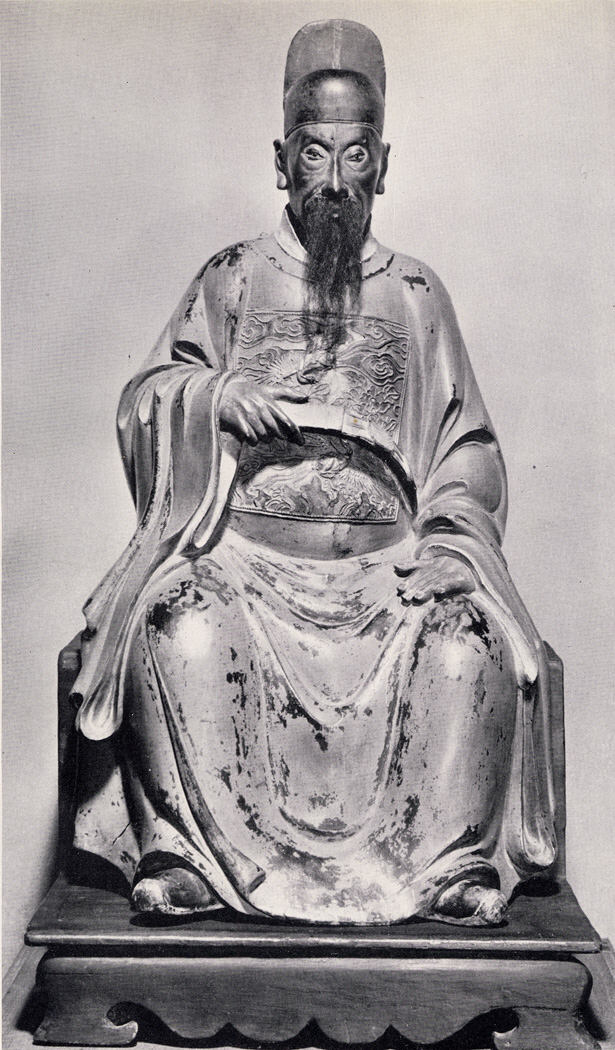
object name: figure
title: Statue of Official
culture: chinese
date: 1368-1644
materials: wood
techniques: gilding, painting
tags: men